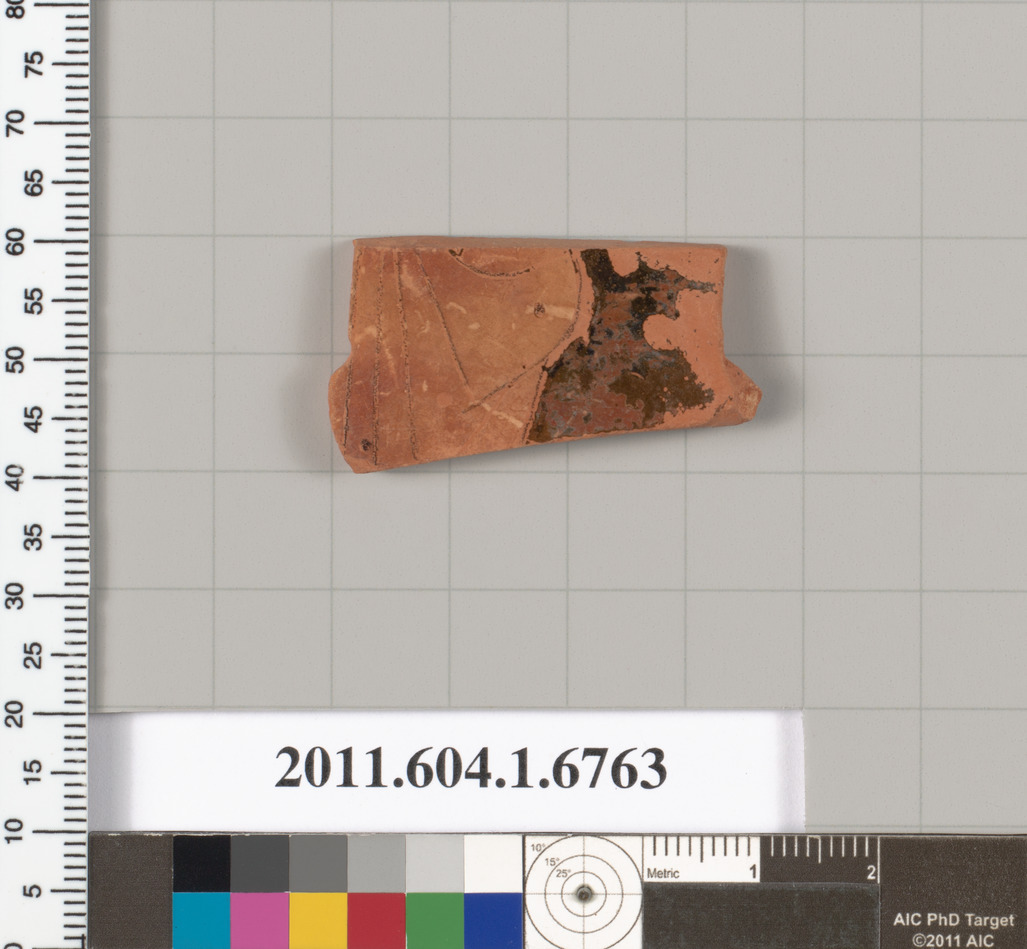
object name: kylix fragment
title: Terracotta fragment of a kylix (drinking cup)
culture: greek, attic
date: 490-470 BCE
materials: terracotta